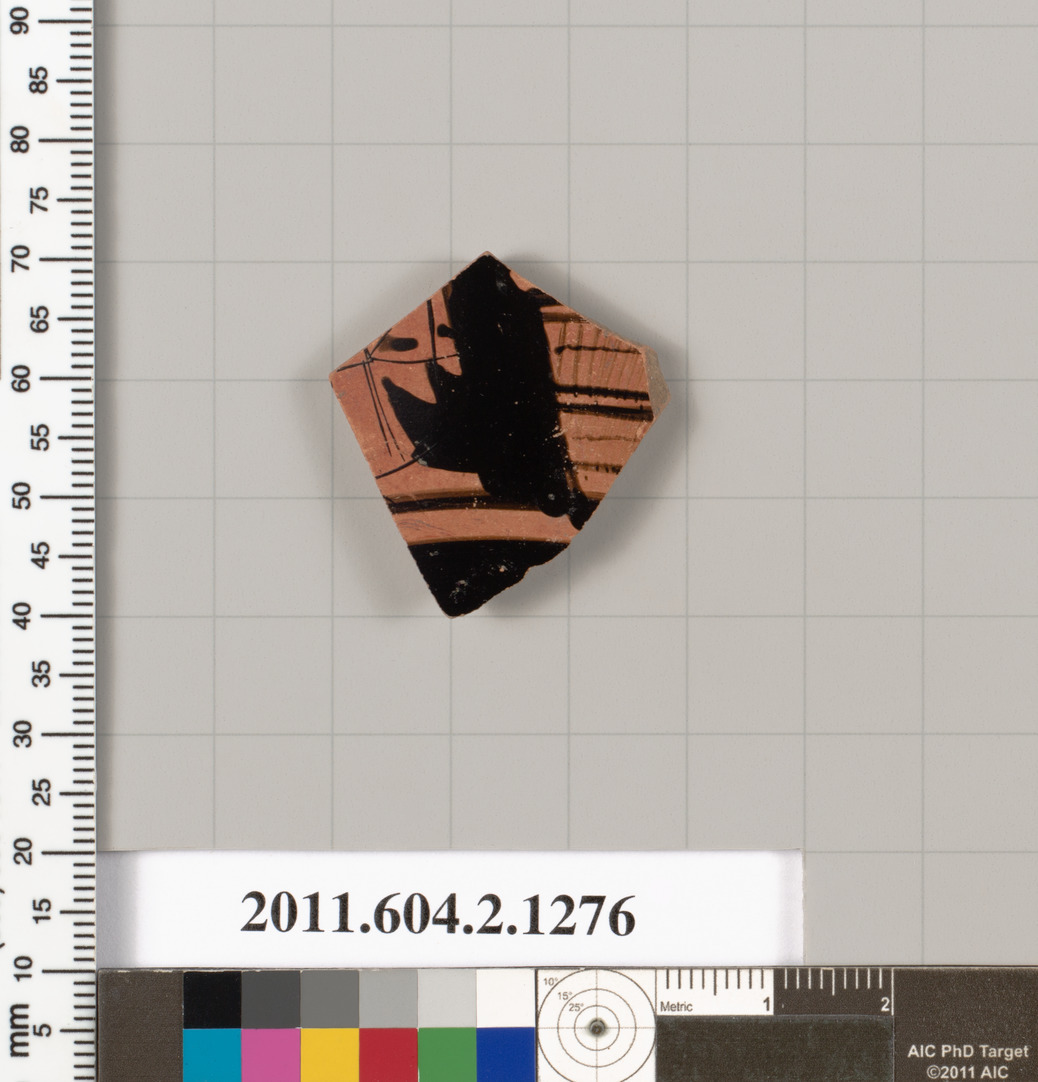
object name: skyphos fragment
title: Terracotta fragment of a skyphos (deep drinking cup)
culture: greek, attic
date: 450-430 BCE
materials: terracotta